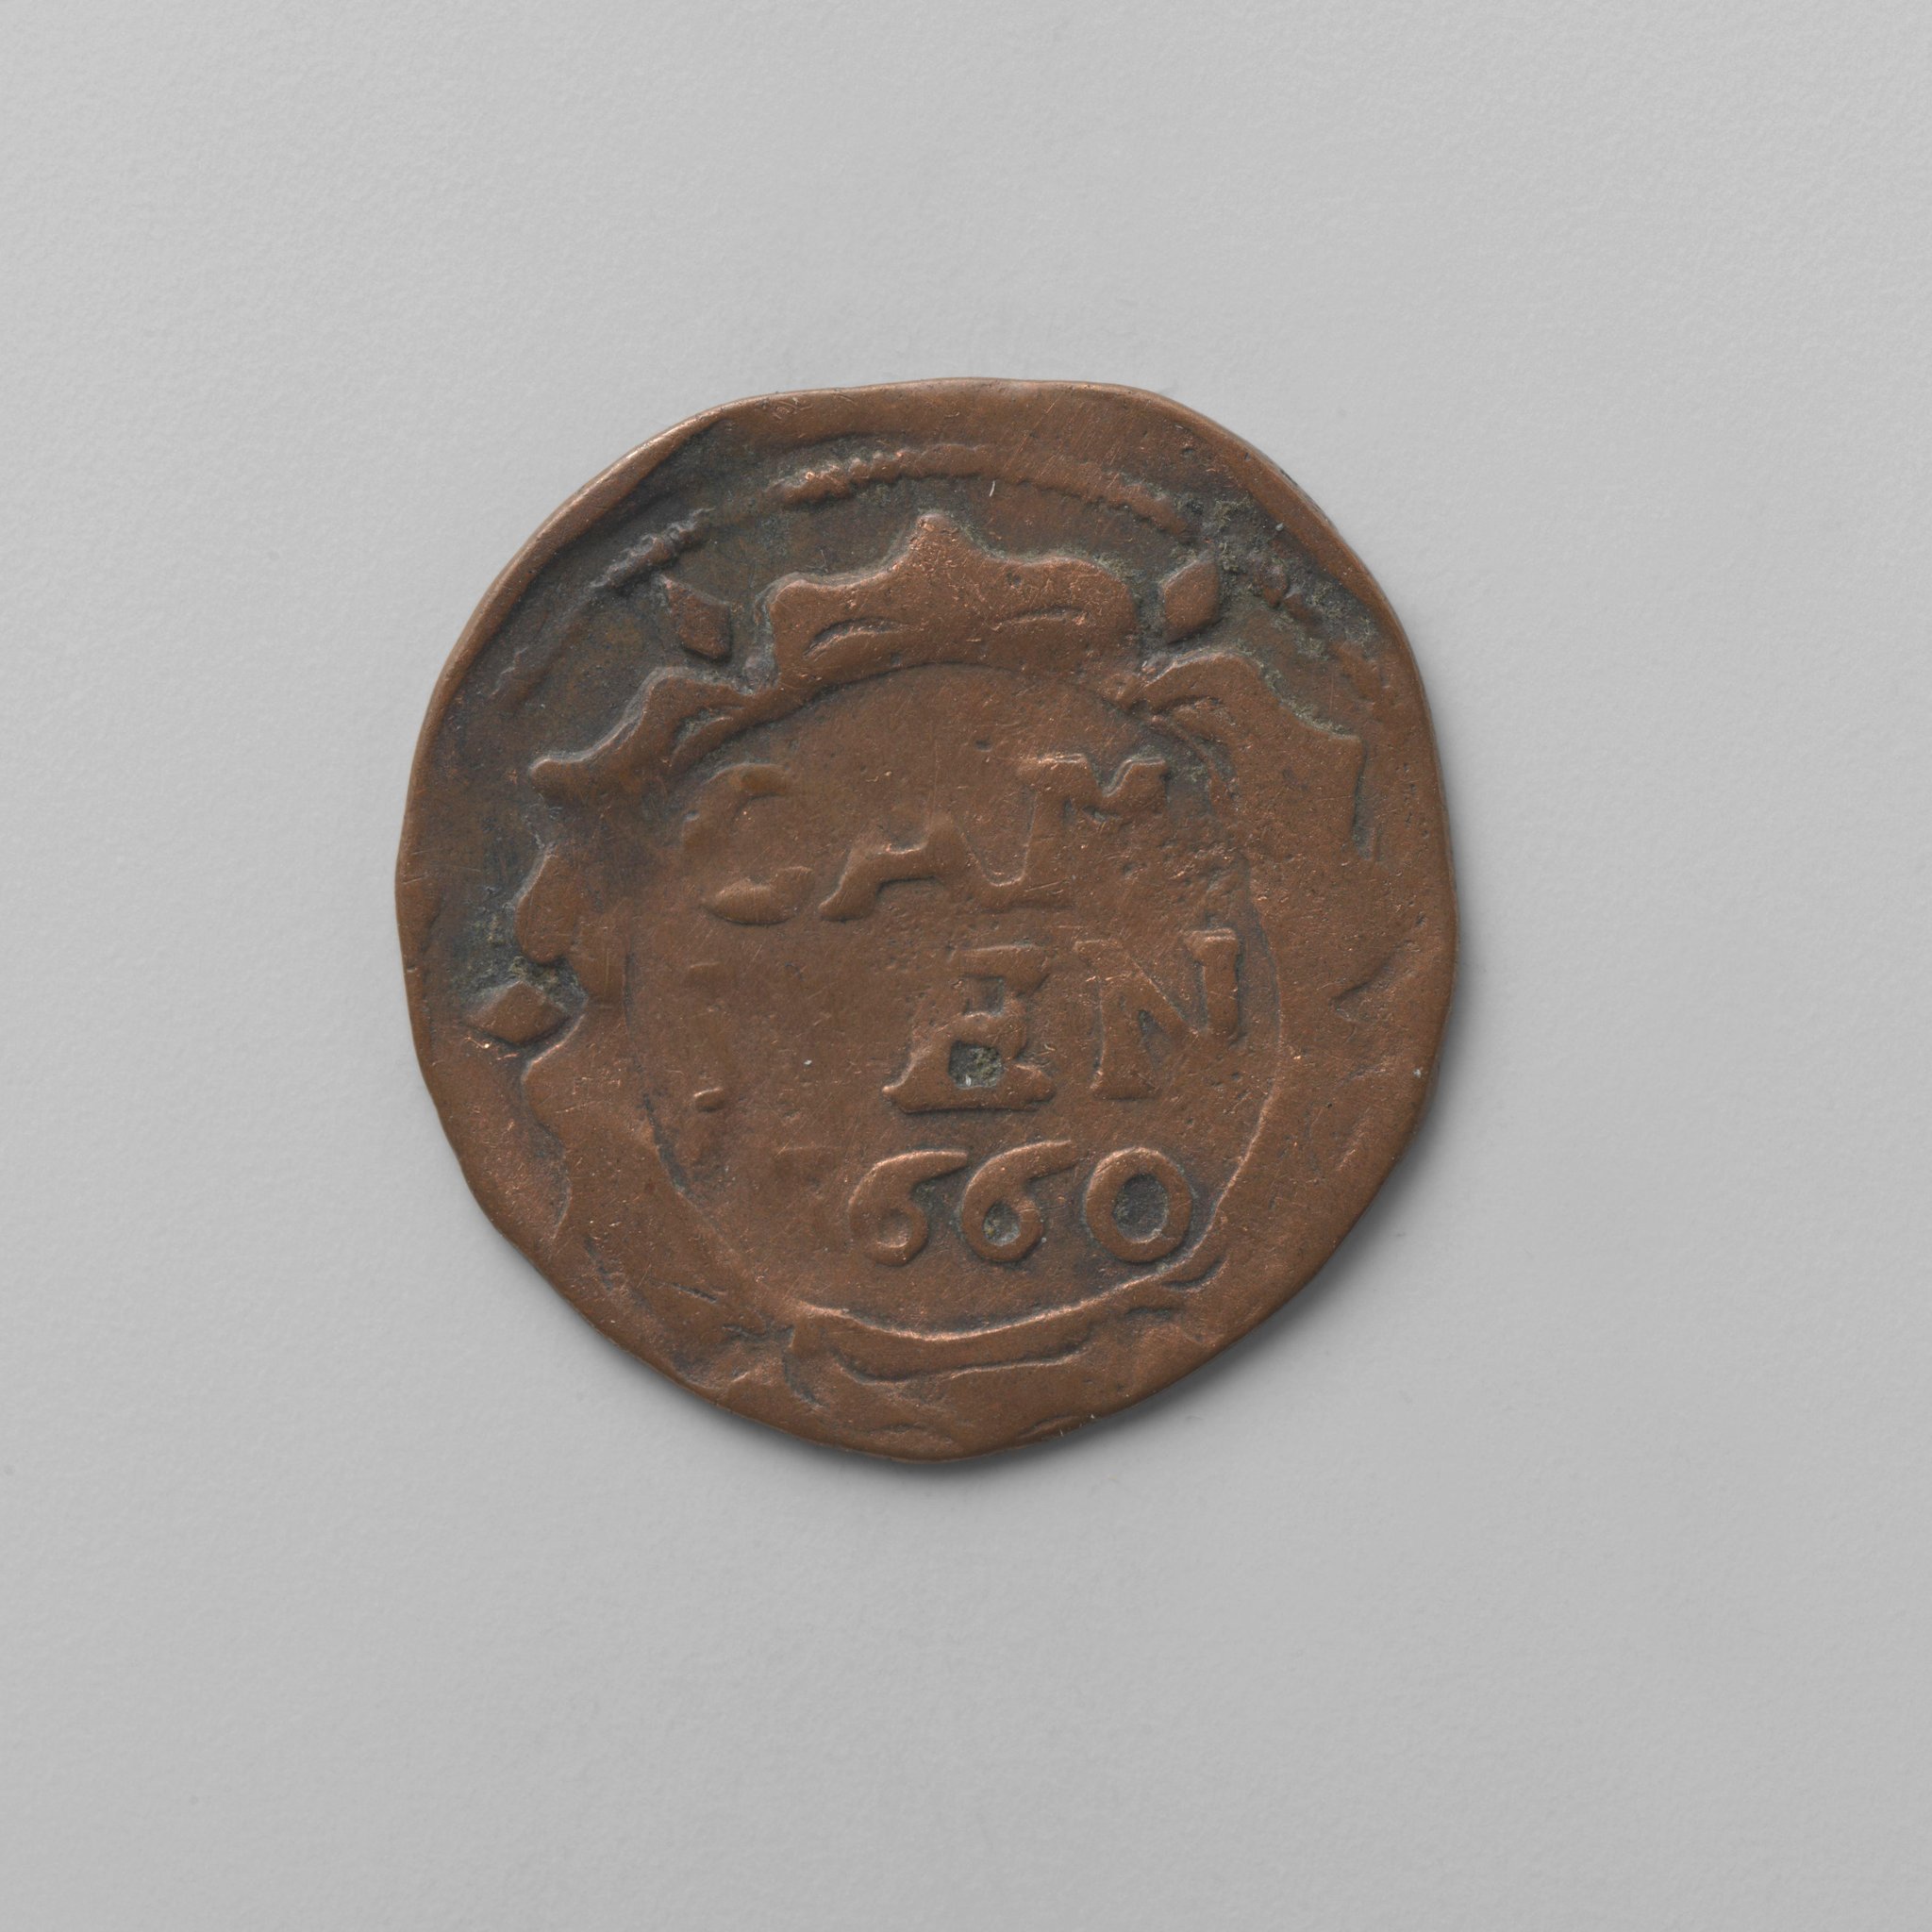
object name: coin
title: Duit van Kampen, 1660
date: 1660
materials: copper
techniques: striking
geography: kampen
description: Koperen munt. Voorzijde: binnen een bladerkrans stadswapen. Keerzijde: binnen een versierde rand tweeregelig opschrift, waaronder jaartal.